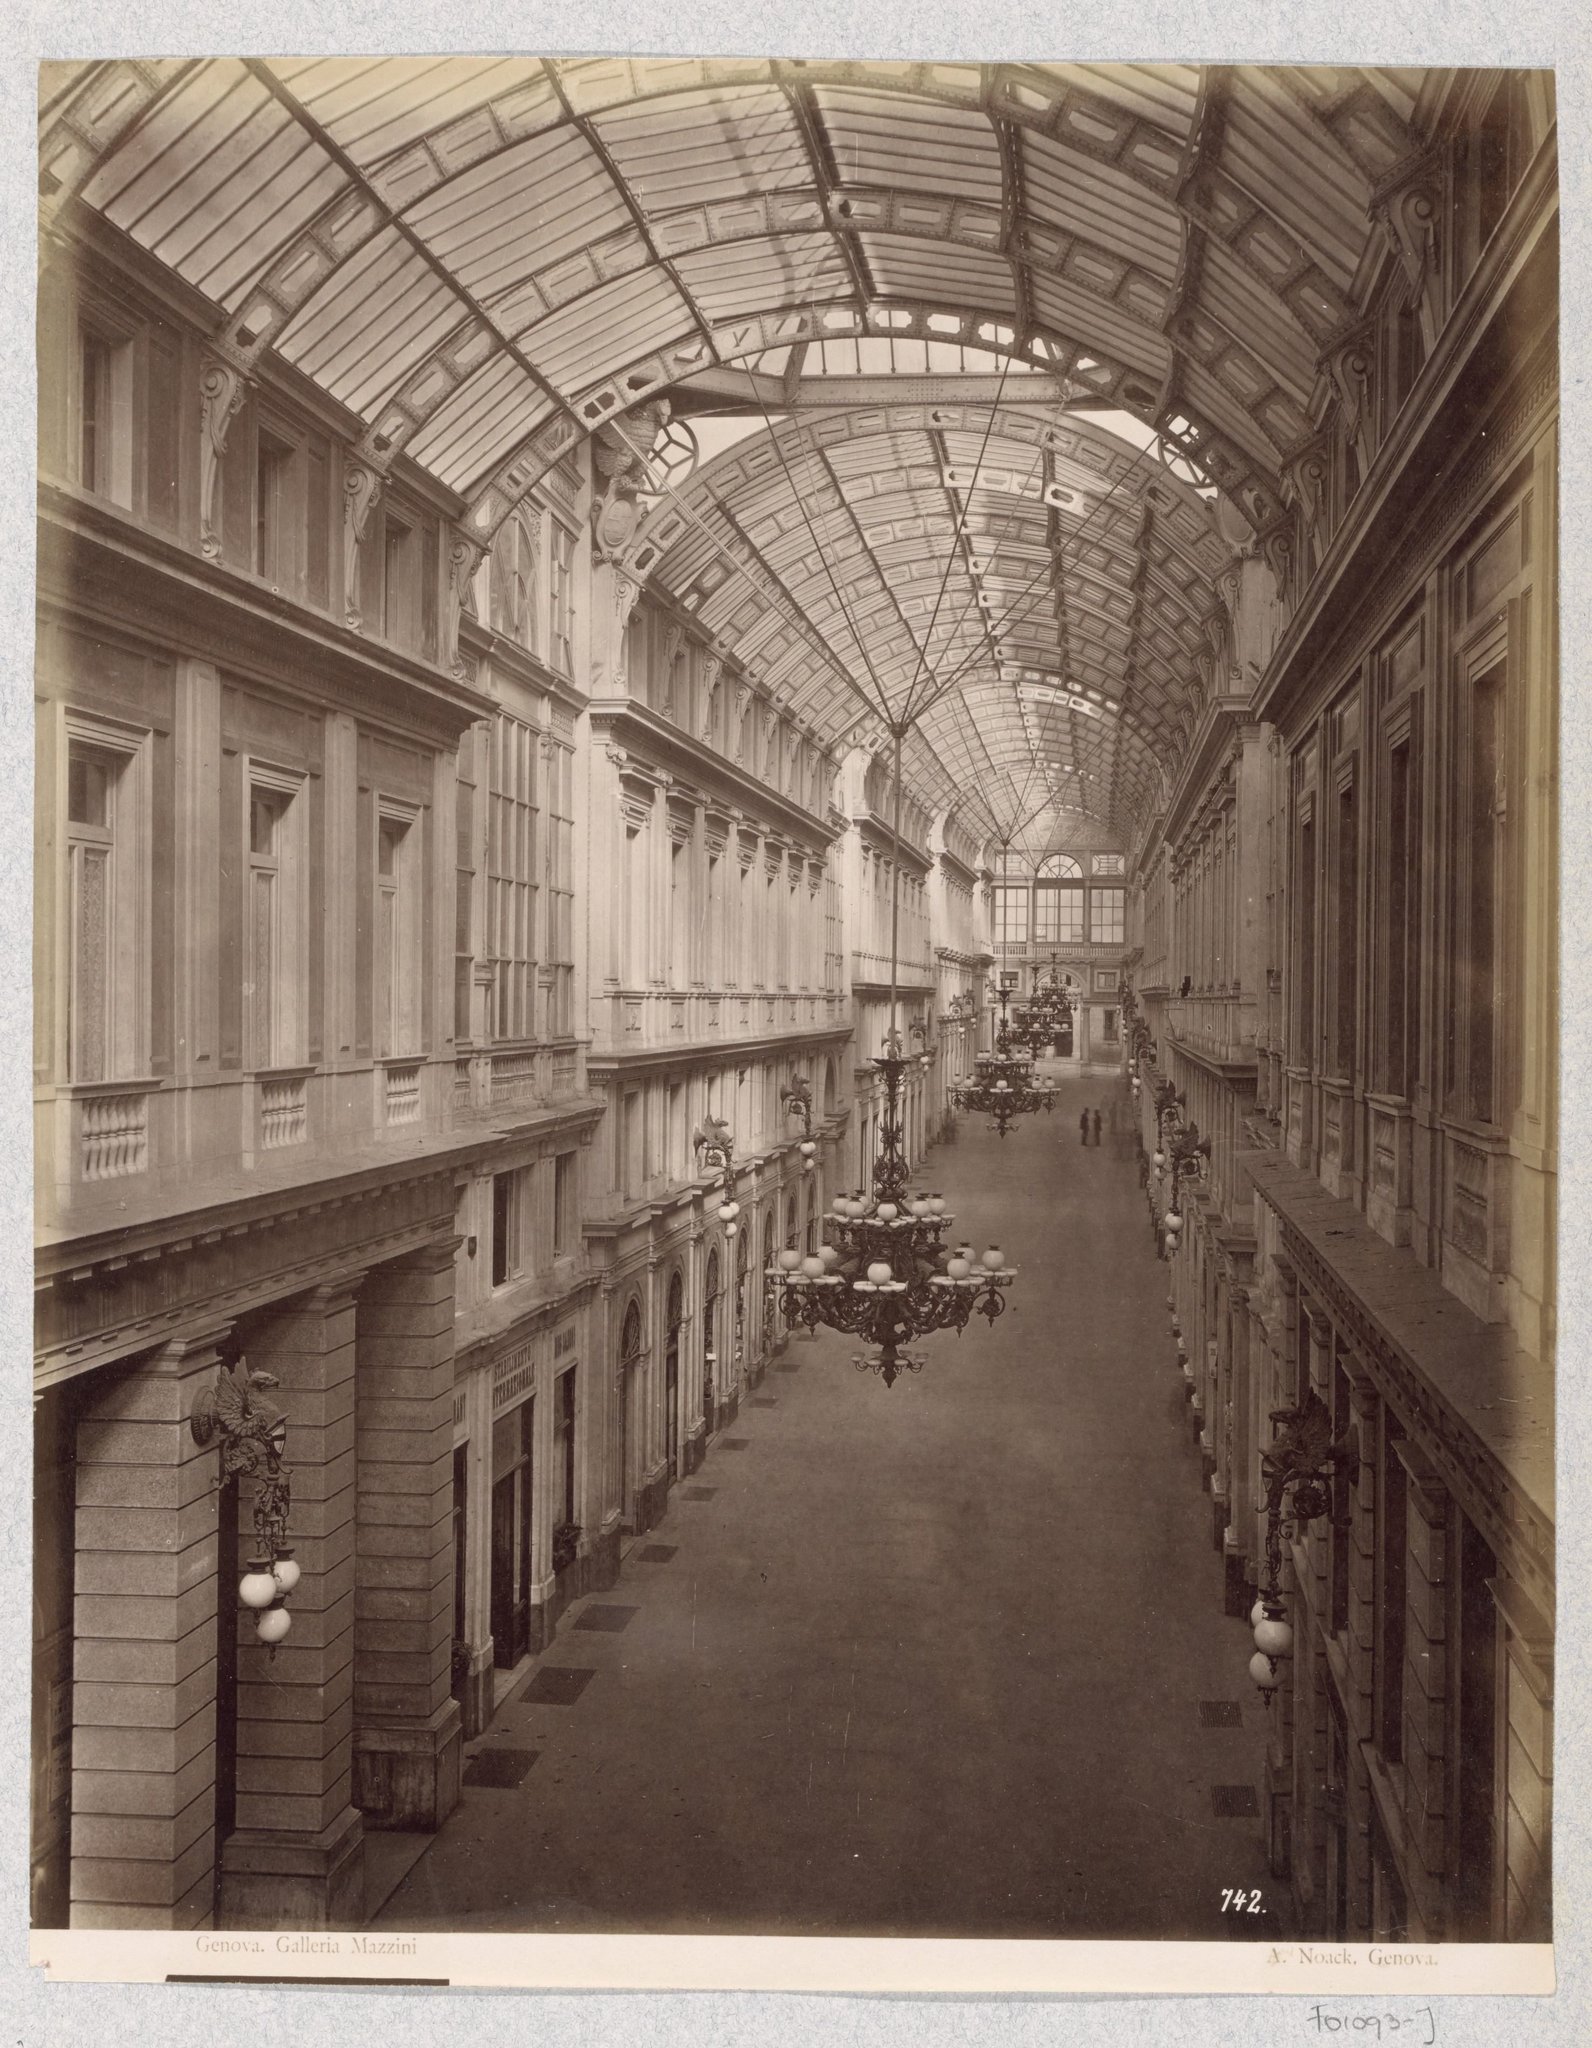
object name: photograph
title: Interieur van de Mazzinigalerij in Genua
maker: alfredo noack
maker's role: fotograaf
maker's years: 1833-1895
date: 1870-1890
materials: paper, photographic support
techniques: albumen print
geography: genoa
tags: gallery (spacious corridor)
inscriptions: negative number: ‘742’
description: Onderdeel van Reisalbum met foto's van bezienswaardigheden in Genua, Florence en Venetië.